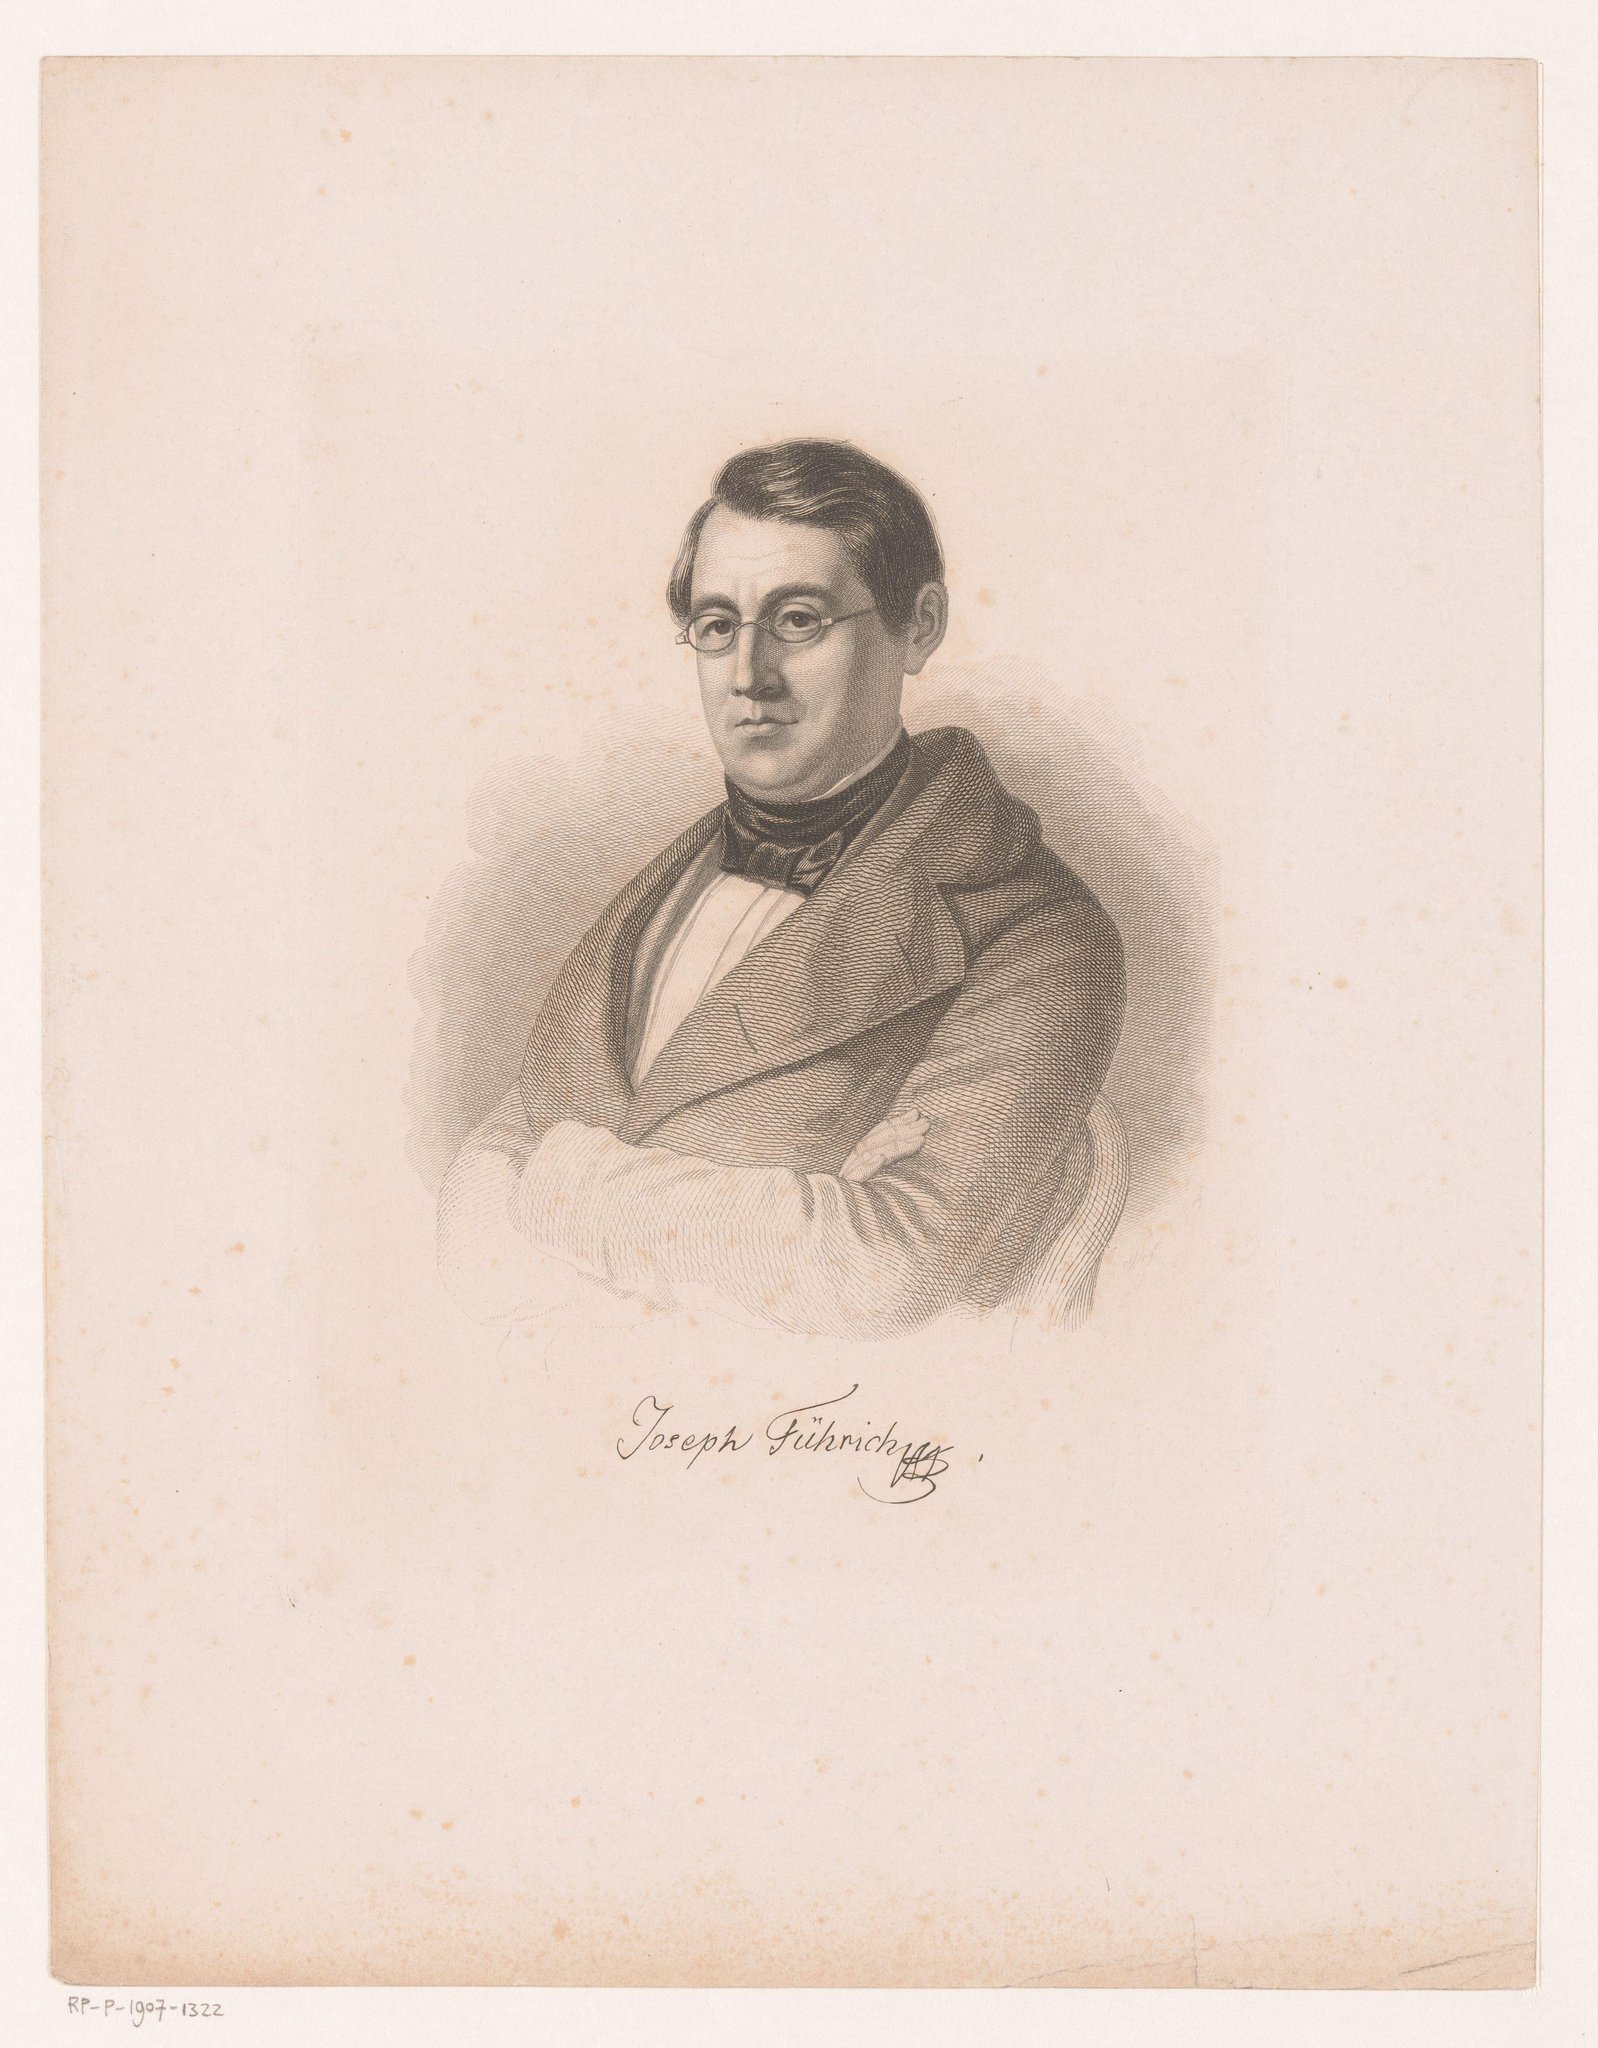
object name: print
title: Portret van Joseph von Führich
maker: august weger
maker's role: print maker, printer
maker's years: 1823-1892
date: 1849-1892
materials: paper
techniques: engraving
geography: leipzig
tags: vienna, painter, print maker, draughtsman, joseph von führich, historical persons, portrait, self-portrait of artist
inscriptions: collector's mark: Lugt 2228